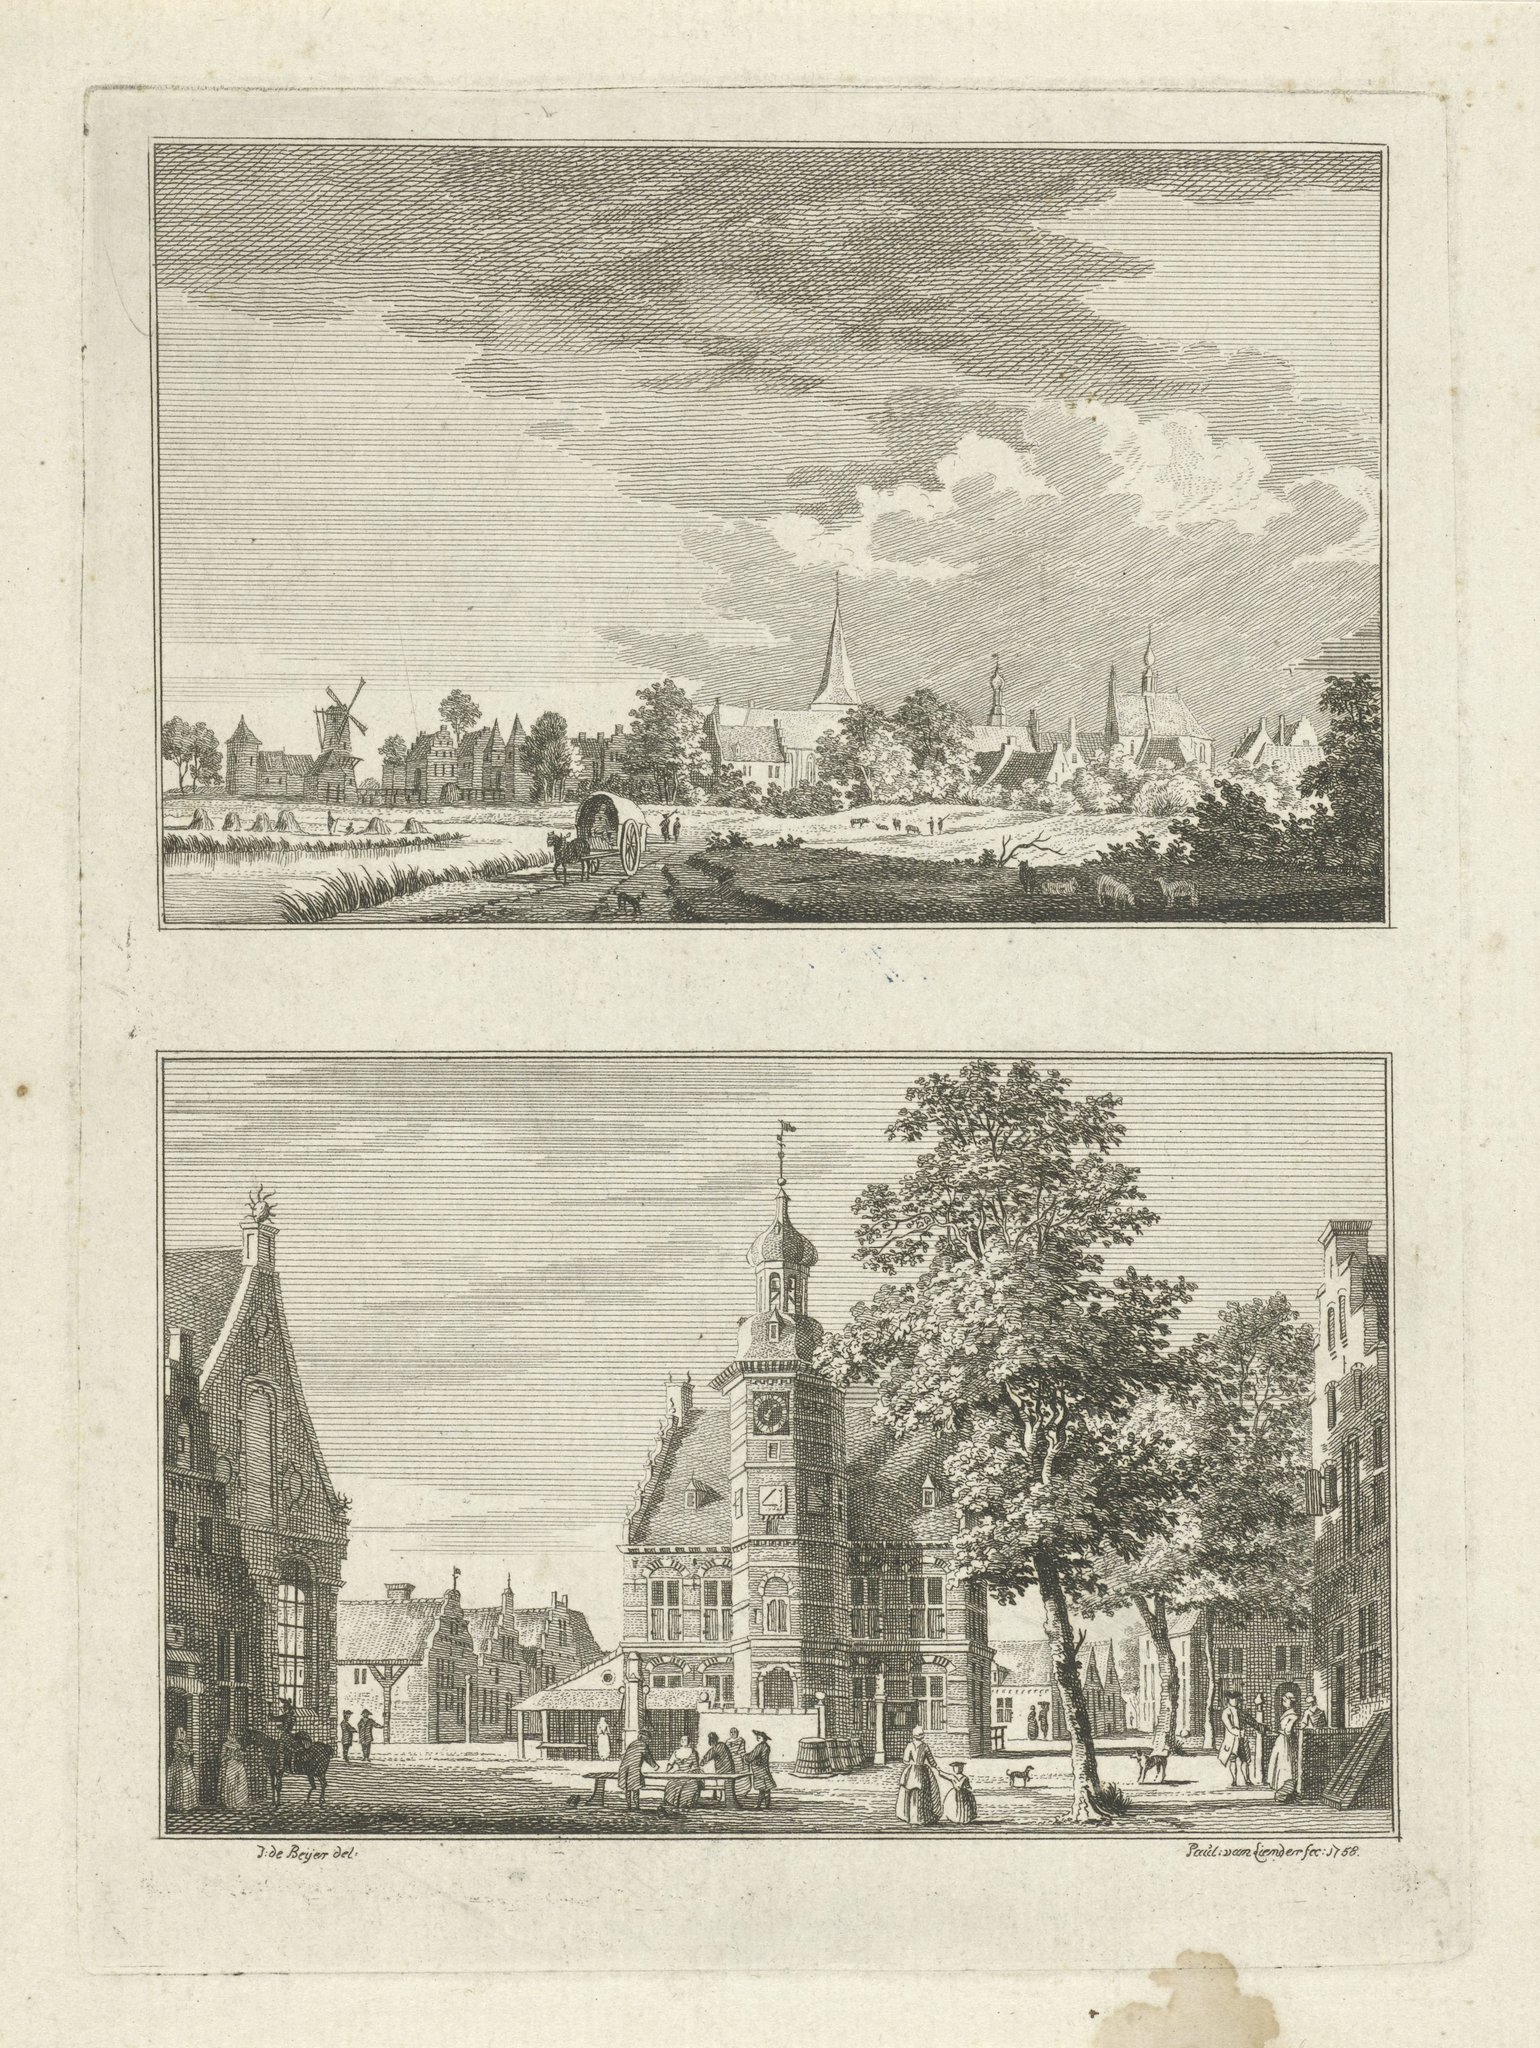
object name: print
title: Dorpsgezichten te Gennep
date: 1760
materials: paper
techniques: etching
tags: city-view in general; 'veduta', townhall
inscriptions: collector's mark: Lugt 2228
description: Twee voorstellingen van één plaat. Gezichten op de stad Gennep (boven) en het raadshuis in het centrum van Gennep (onder). De prent maakt deel uit van een 100-delige serie met gezichten op dorpen en steden te Kleef.